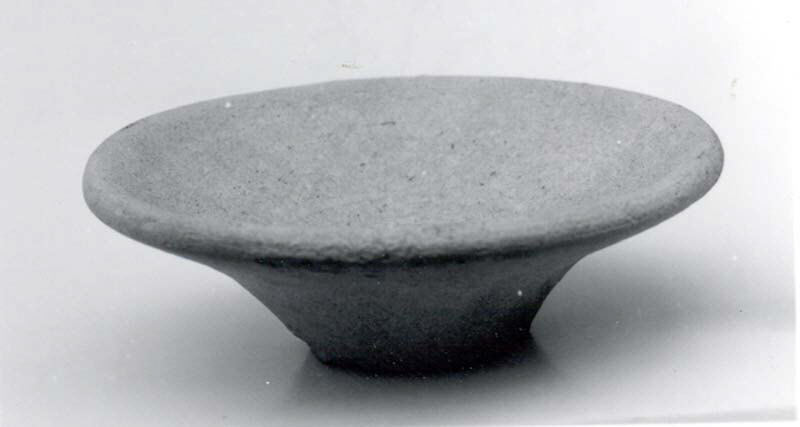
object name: bowl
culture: sasanian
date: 201-700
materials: ceramic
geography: mesopotamia